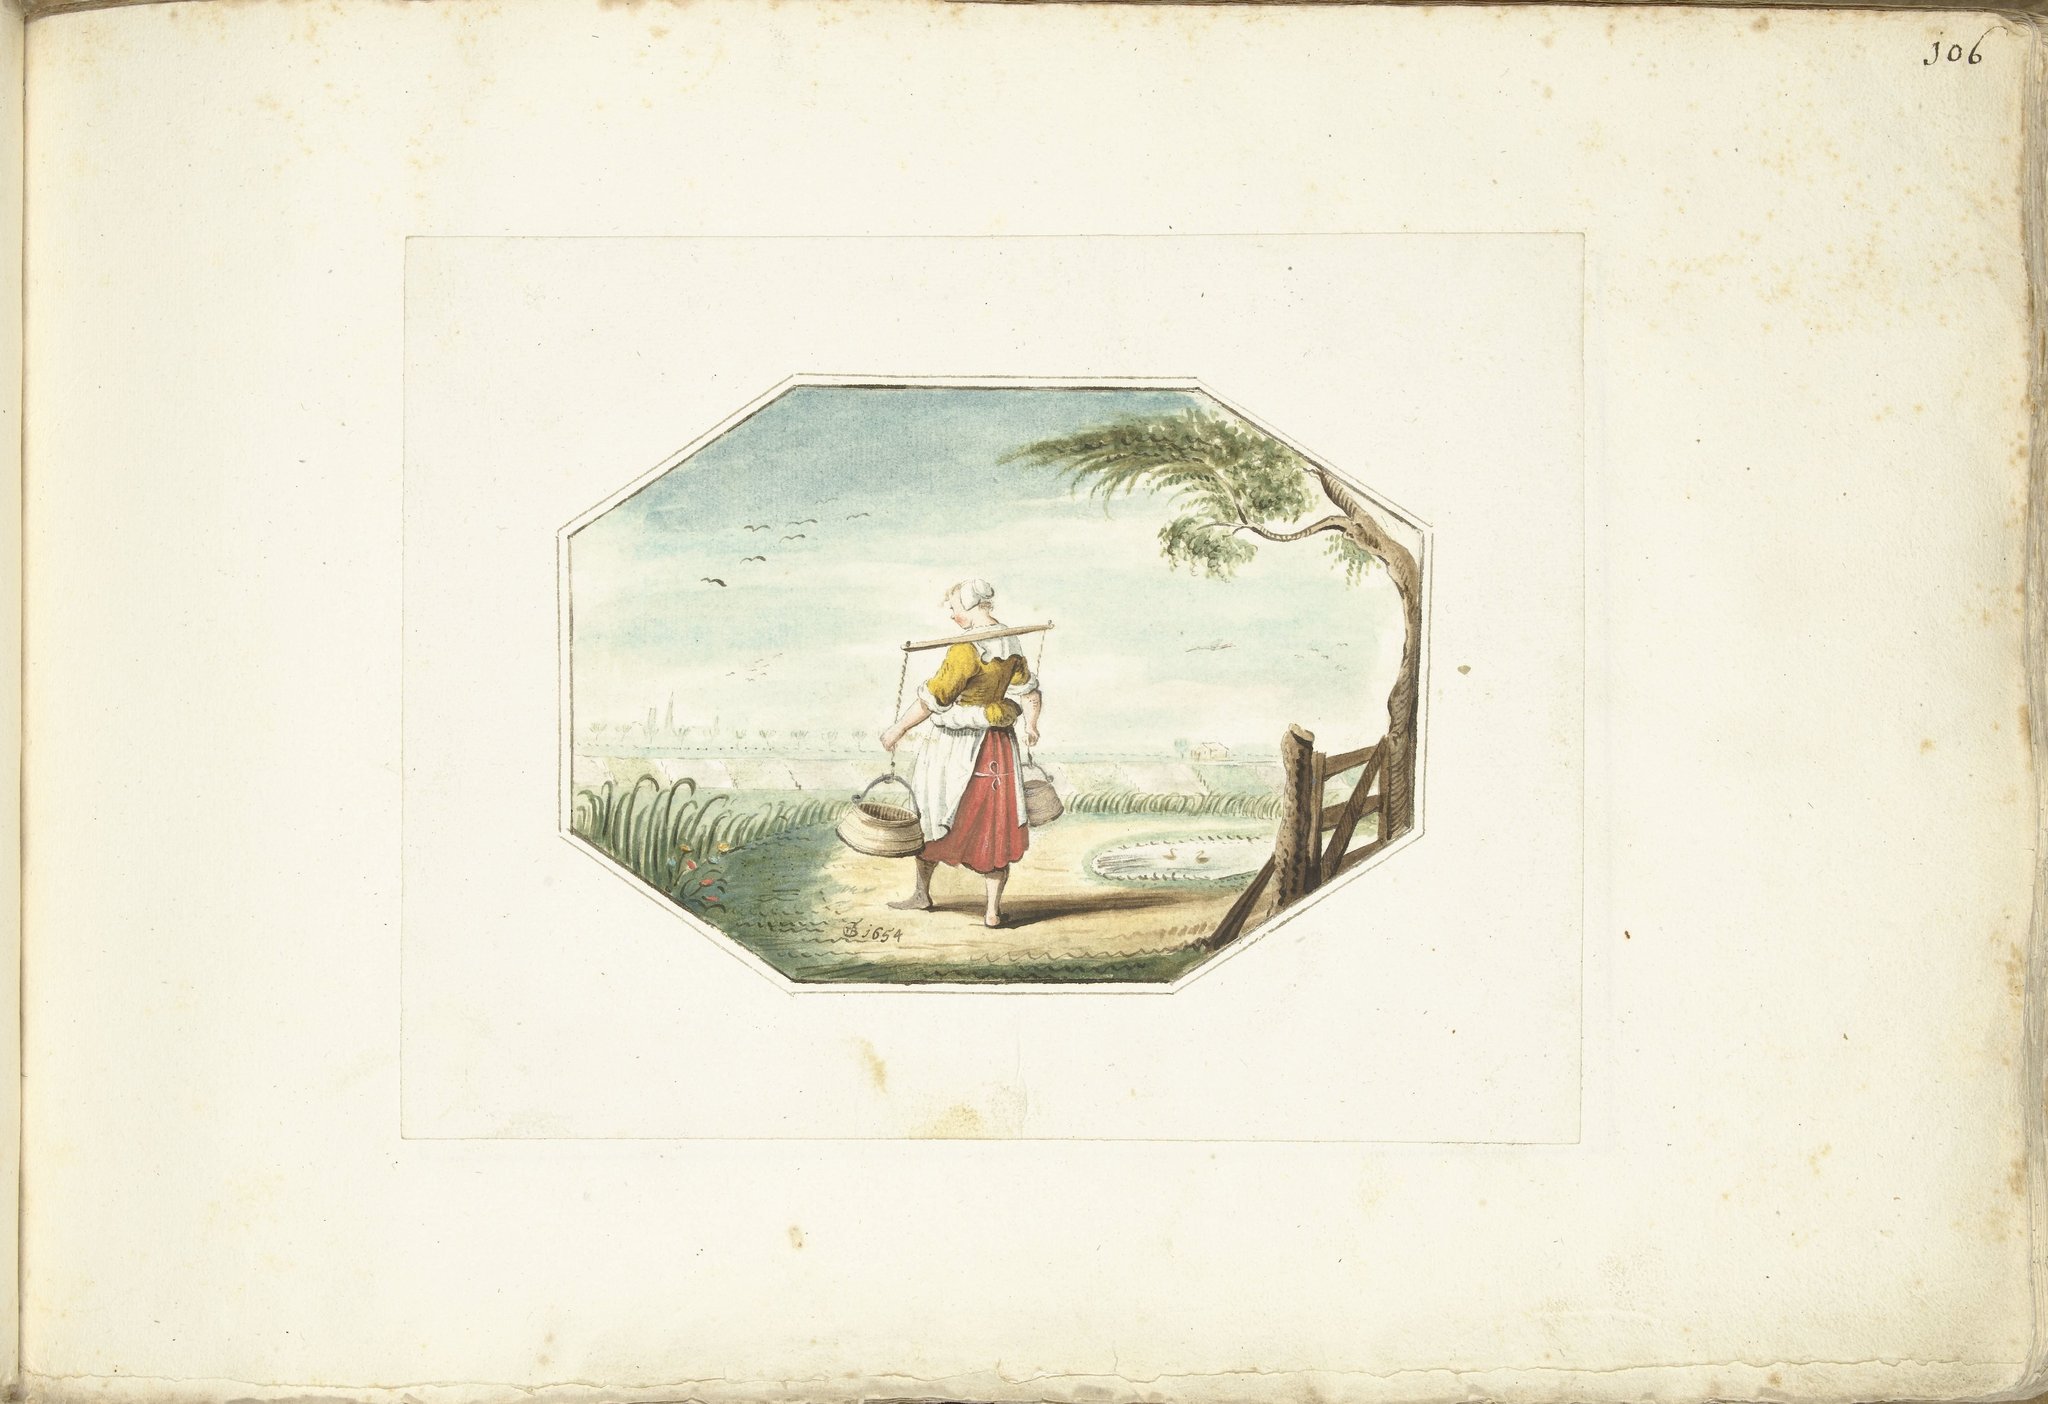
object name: drawing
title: Melkmeid met emmers in een landschap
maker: gesina ter borch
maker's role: draughtsman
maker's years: 1633-1690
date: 1654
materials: ink, paper, watercolor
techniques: brush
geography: zwolle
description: De achthoekige tekening is opgeplakt op een blad dat weer in het Familie-plakboek is geplakt.